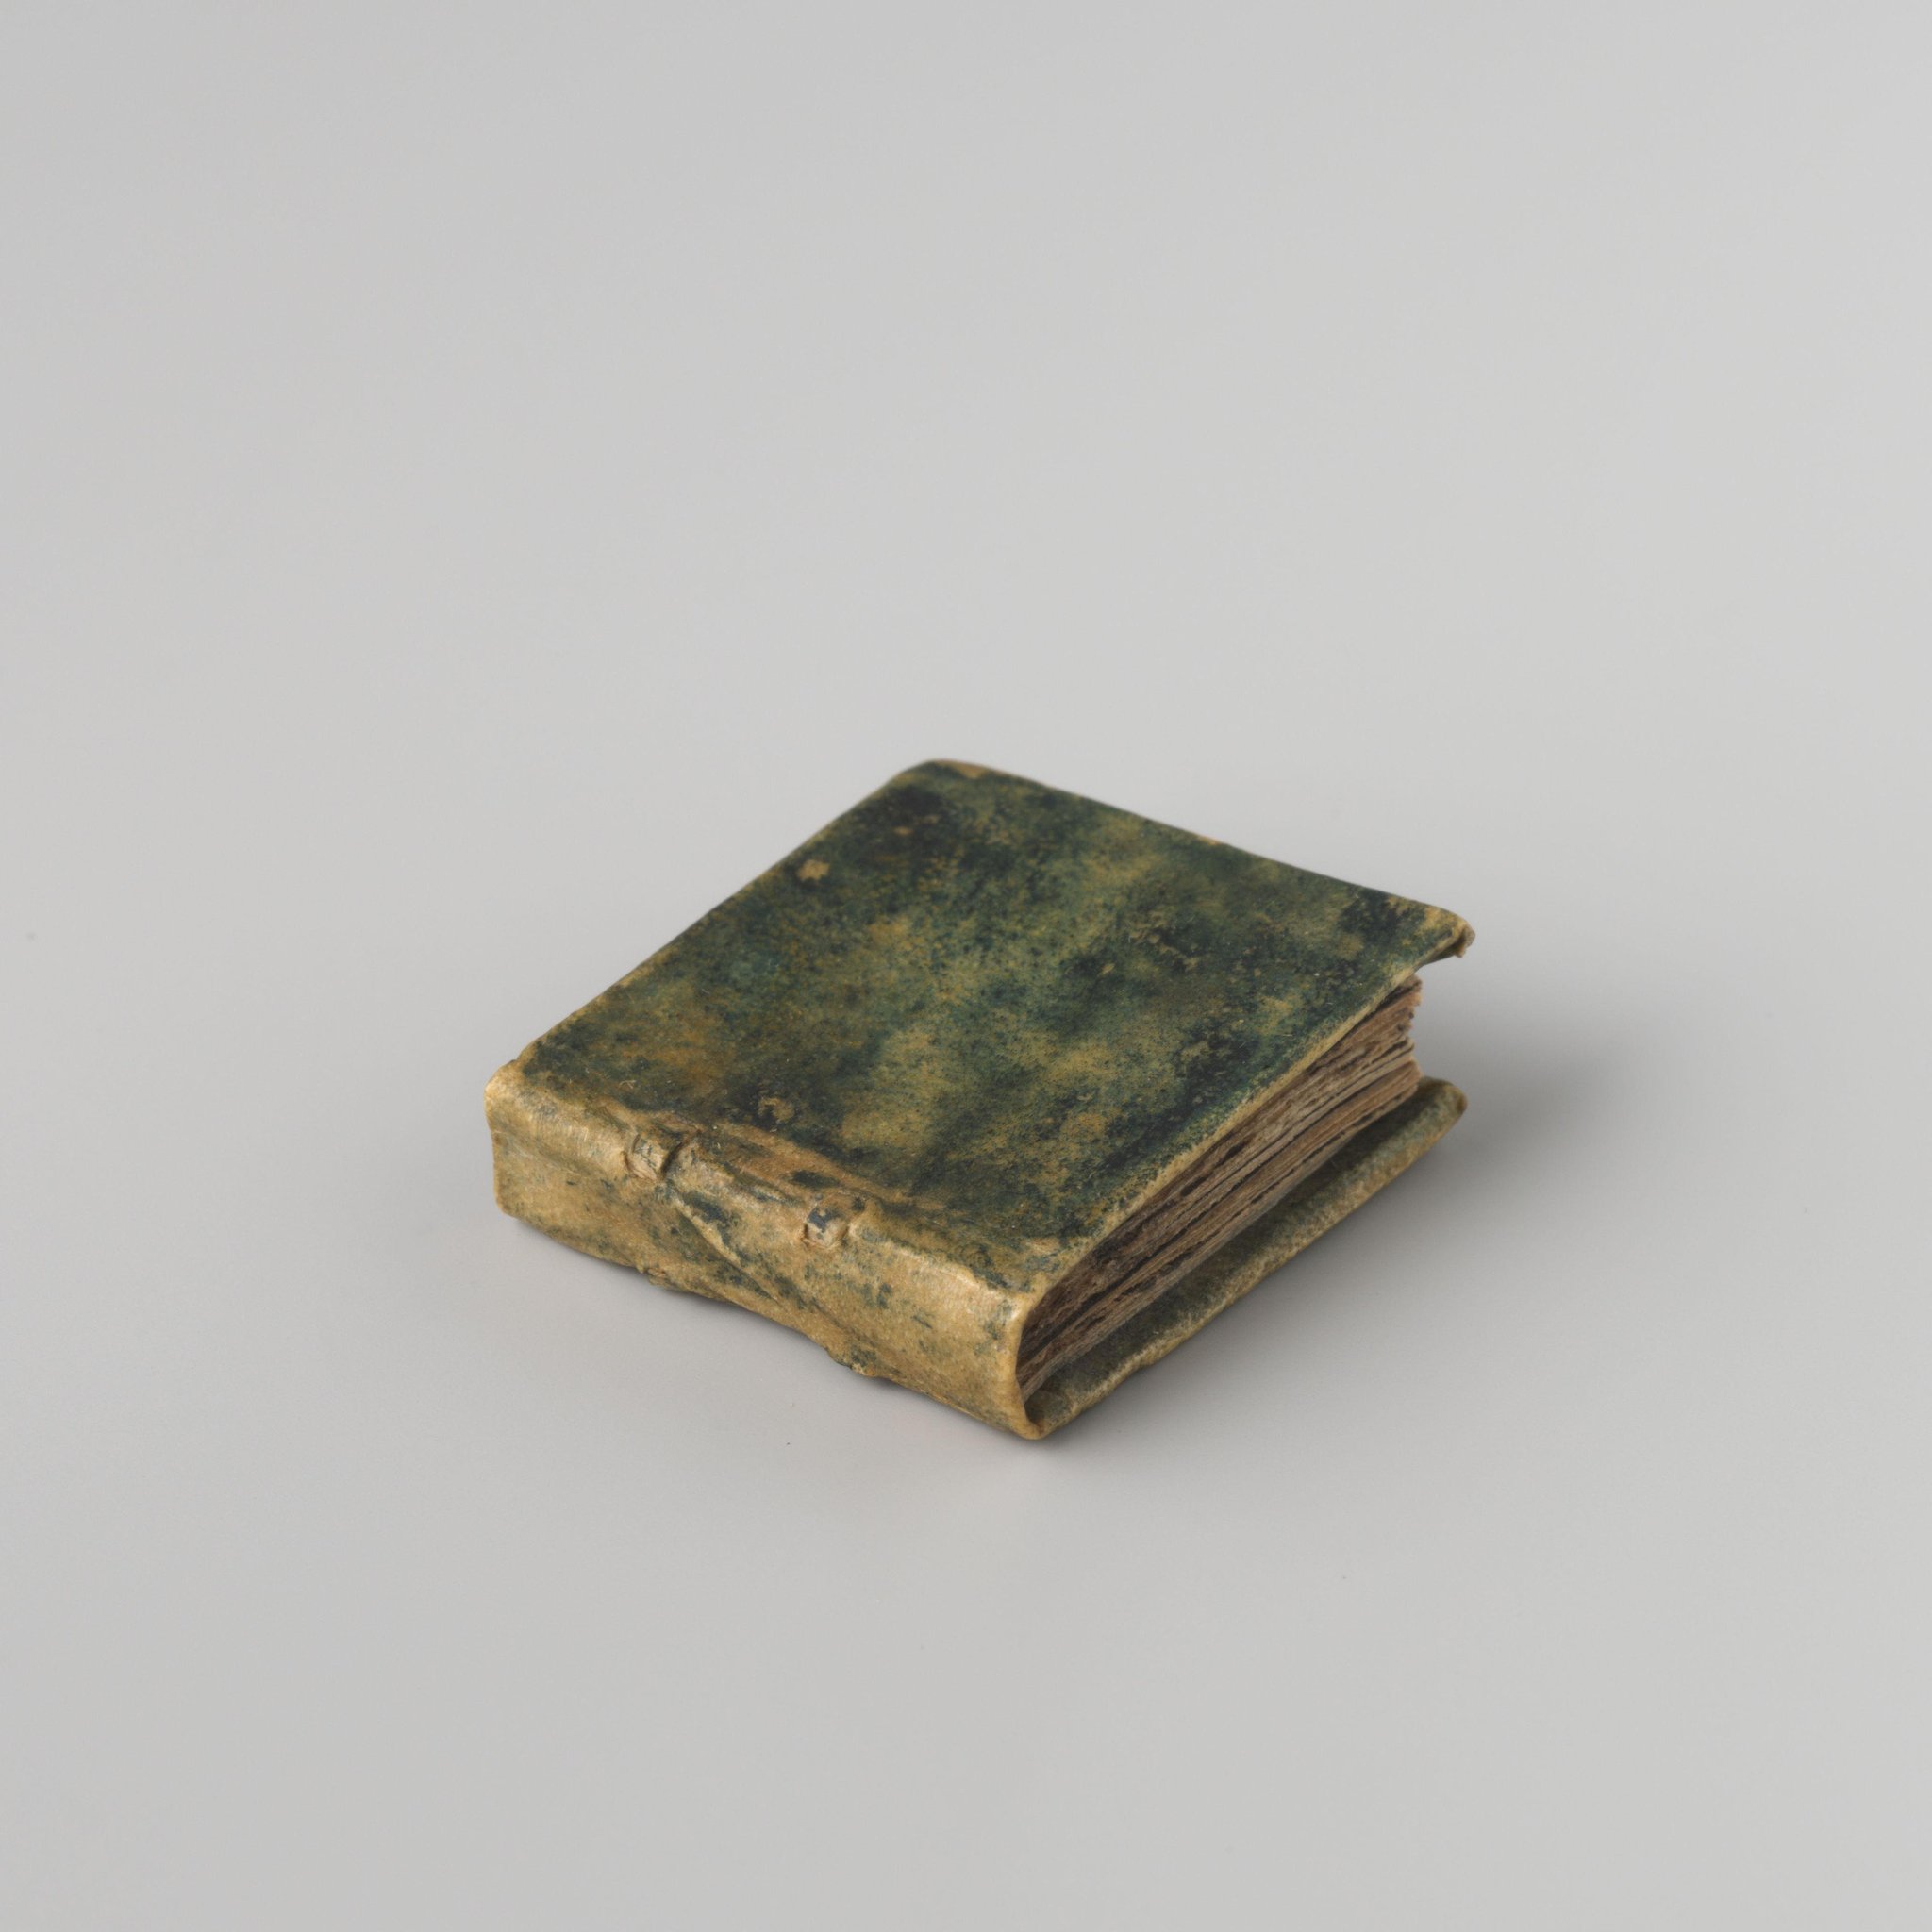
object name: miniature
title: Boek met stads- en tuingezichten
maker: Anonymous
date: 1690-1710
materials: leather, paper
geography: amsterdam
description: Boek met stads- en tuingezichten. Ingebonden in blauw gekleurd perkament.